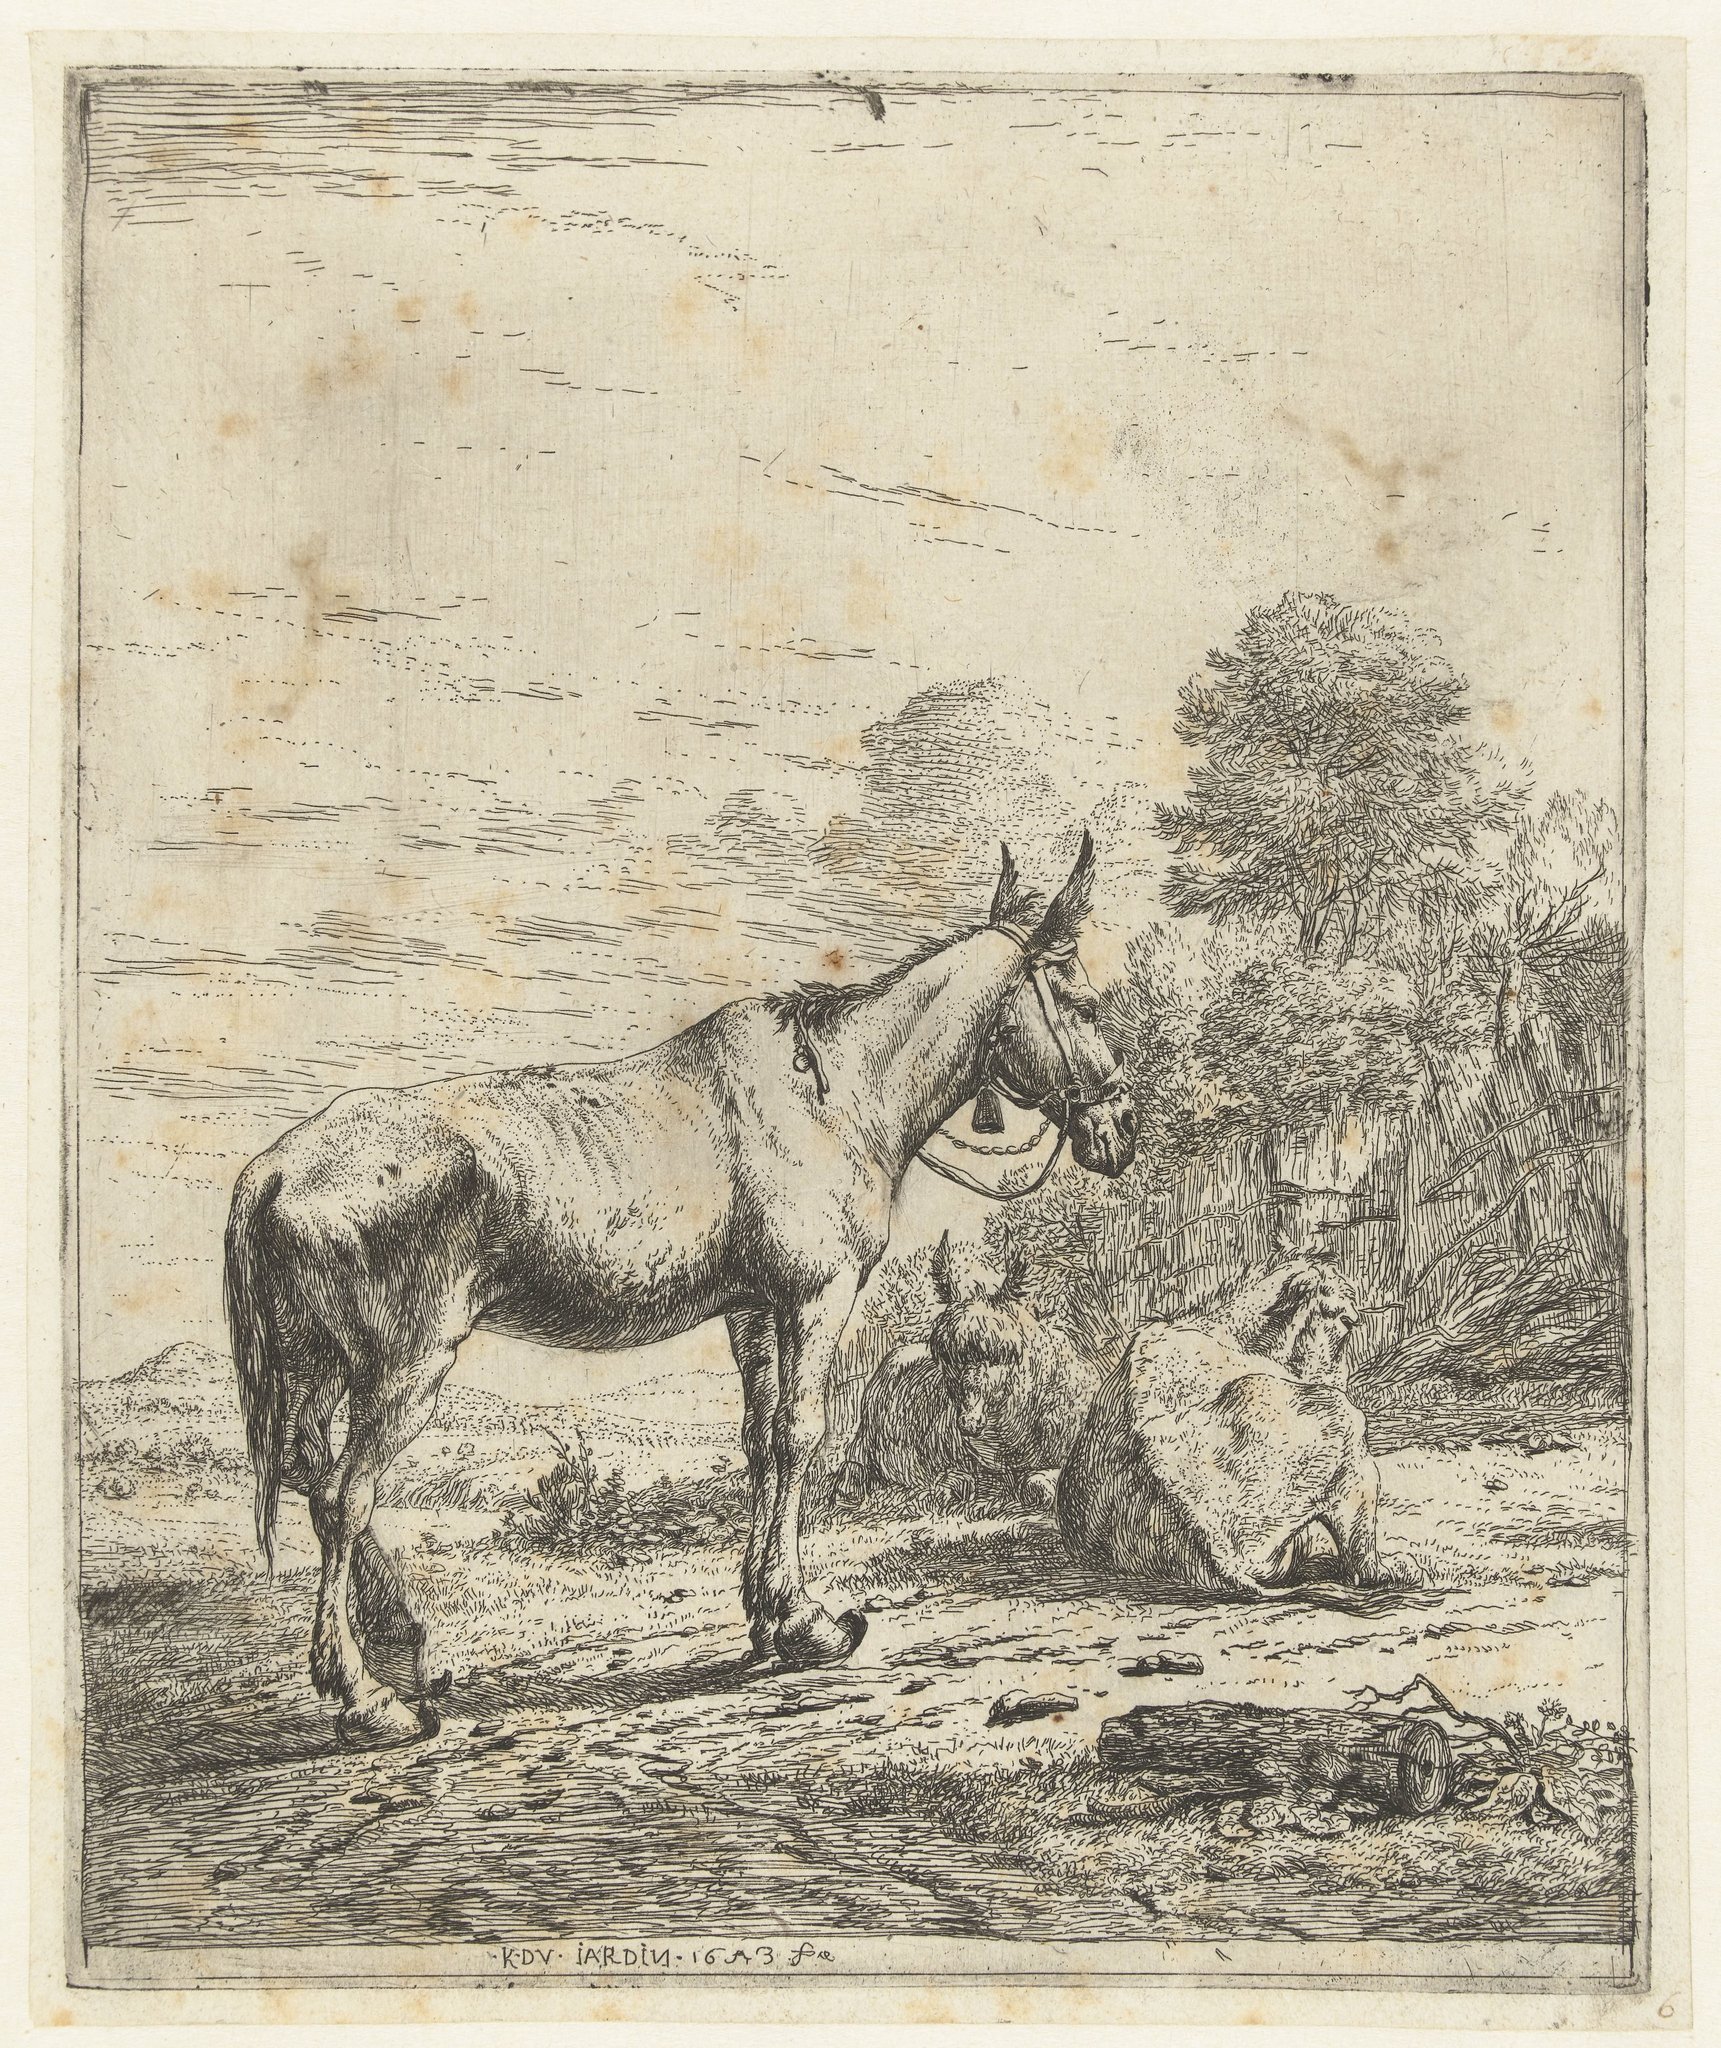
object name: print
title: Muilezel met bel aan halster en twee liggende ezels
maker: karel du jardin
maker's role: draughtsman, painter, print maker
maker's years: 1626-1678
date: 1653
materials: paper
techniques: etching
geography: amsterdam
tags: ass, donkey, mule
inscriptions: collector's mark: Lugt 11, collector's mark: Lugt 10